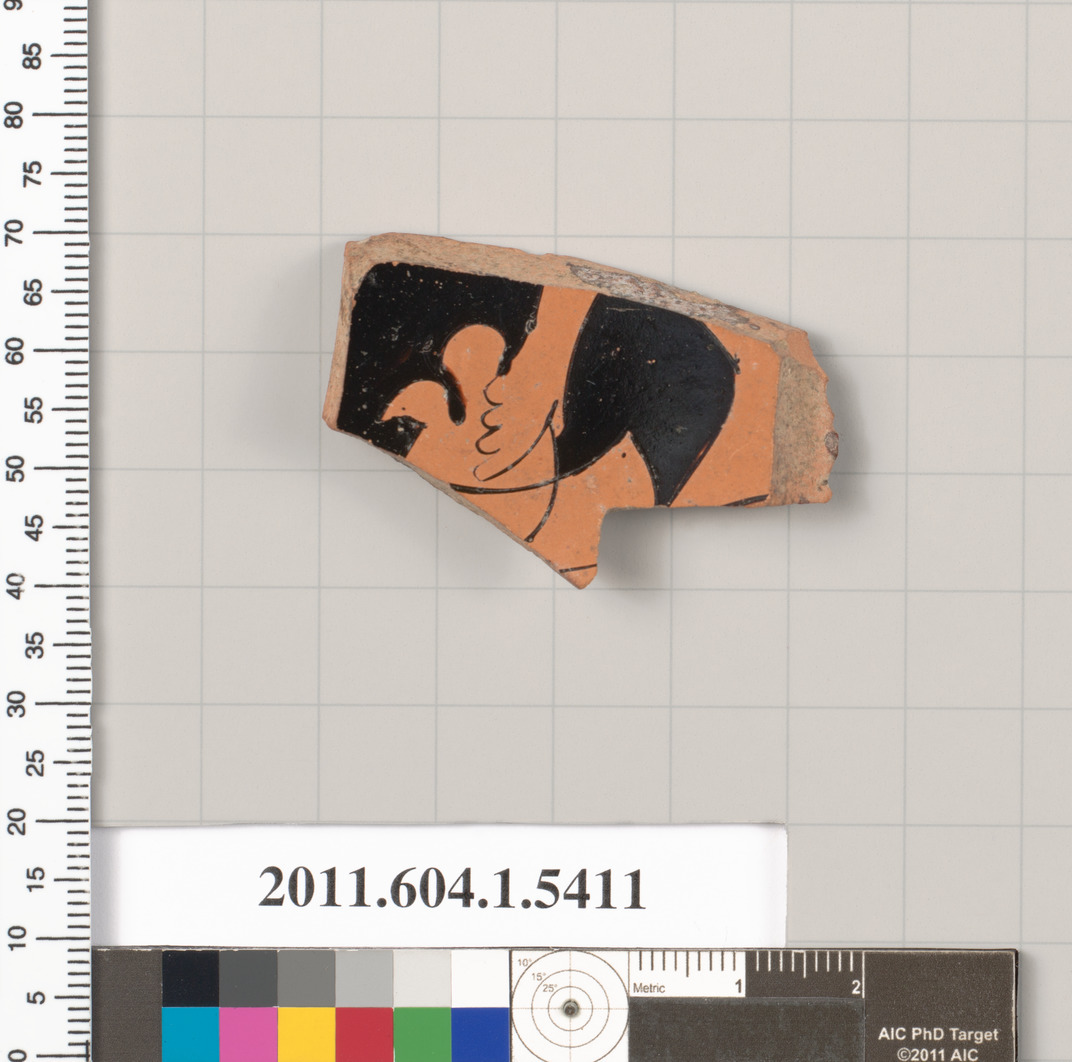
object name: kylix fragment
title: Terracotta fragment of a kylix (drinking cup)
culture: greek, attic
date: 490-480 BCE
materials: terracotta